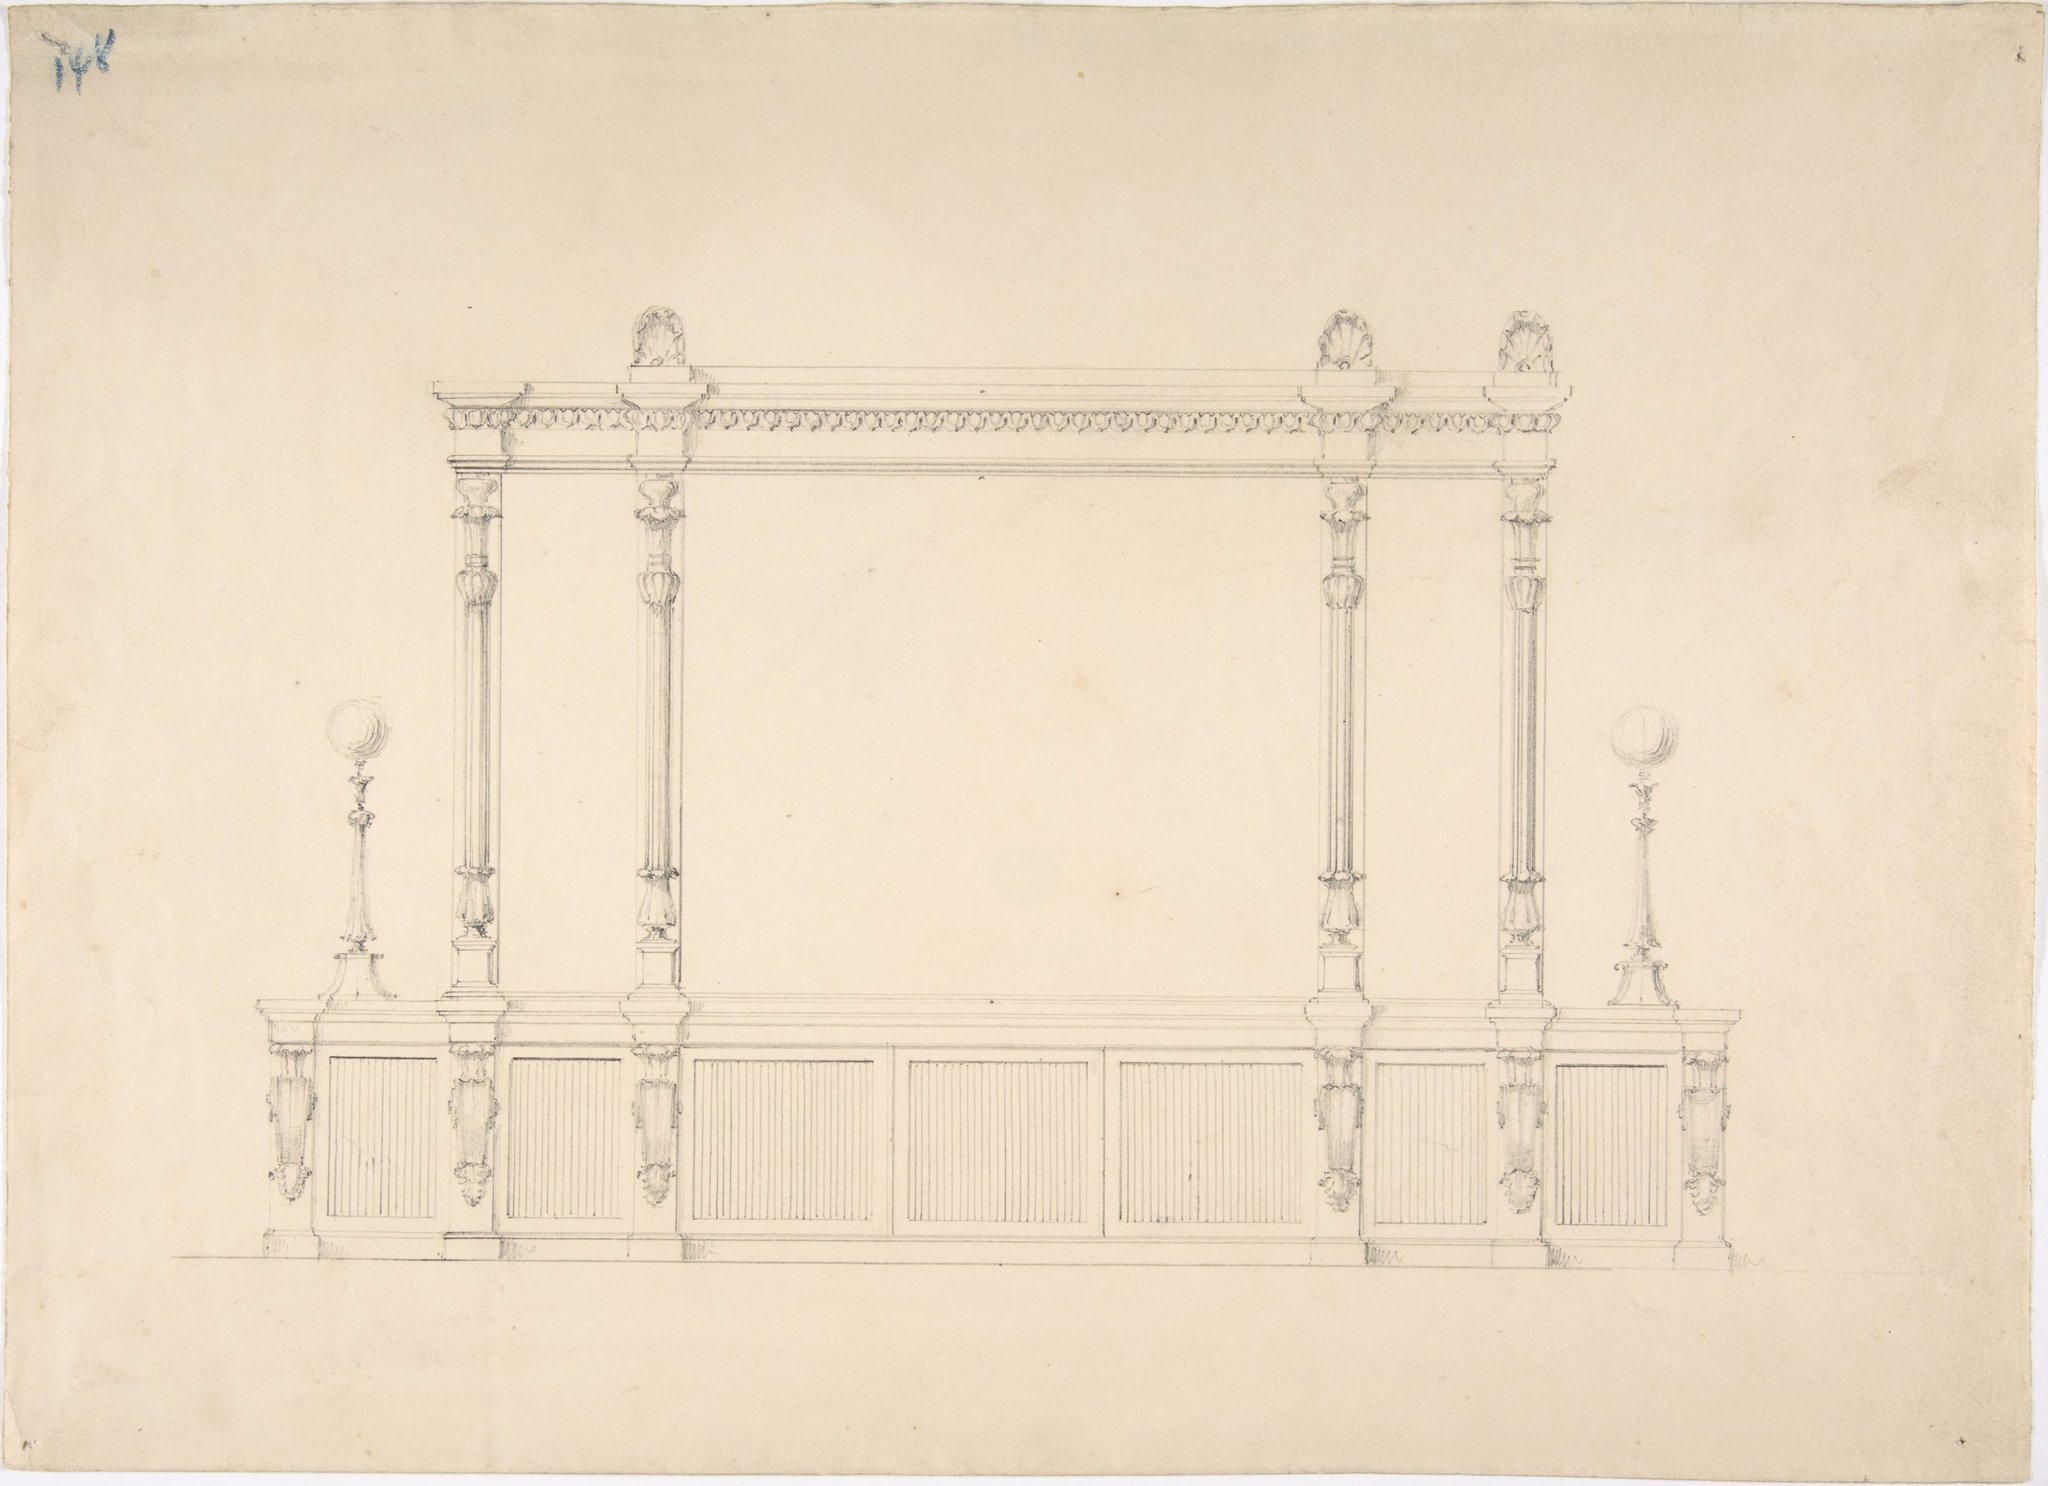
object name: drawing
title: Design for a Very Large Cabinet, with Renaissance Ornament and Lamps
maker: anonymous, british, 19th century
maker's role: artist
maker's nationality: british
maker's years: 1800-1900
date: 1801-1833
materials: graphite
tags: cabinets